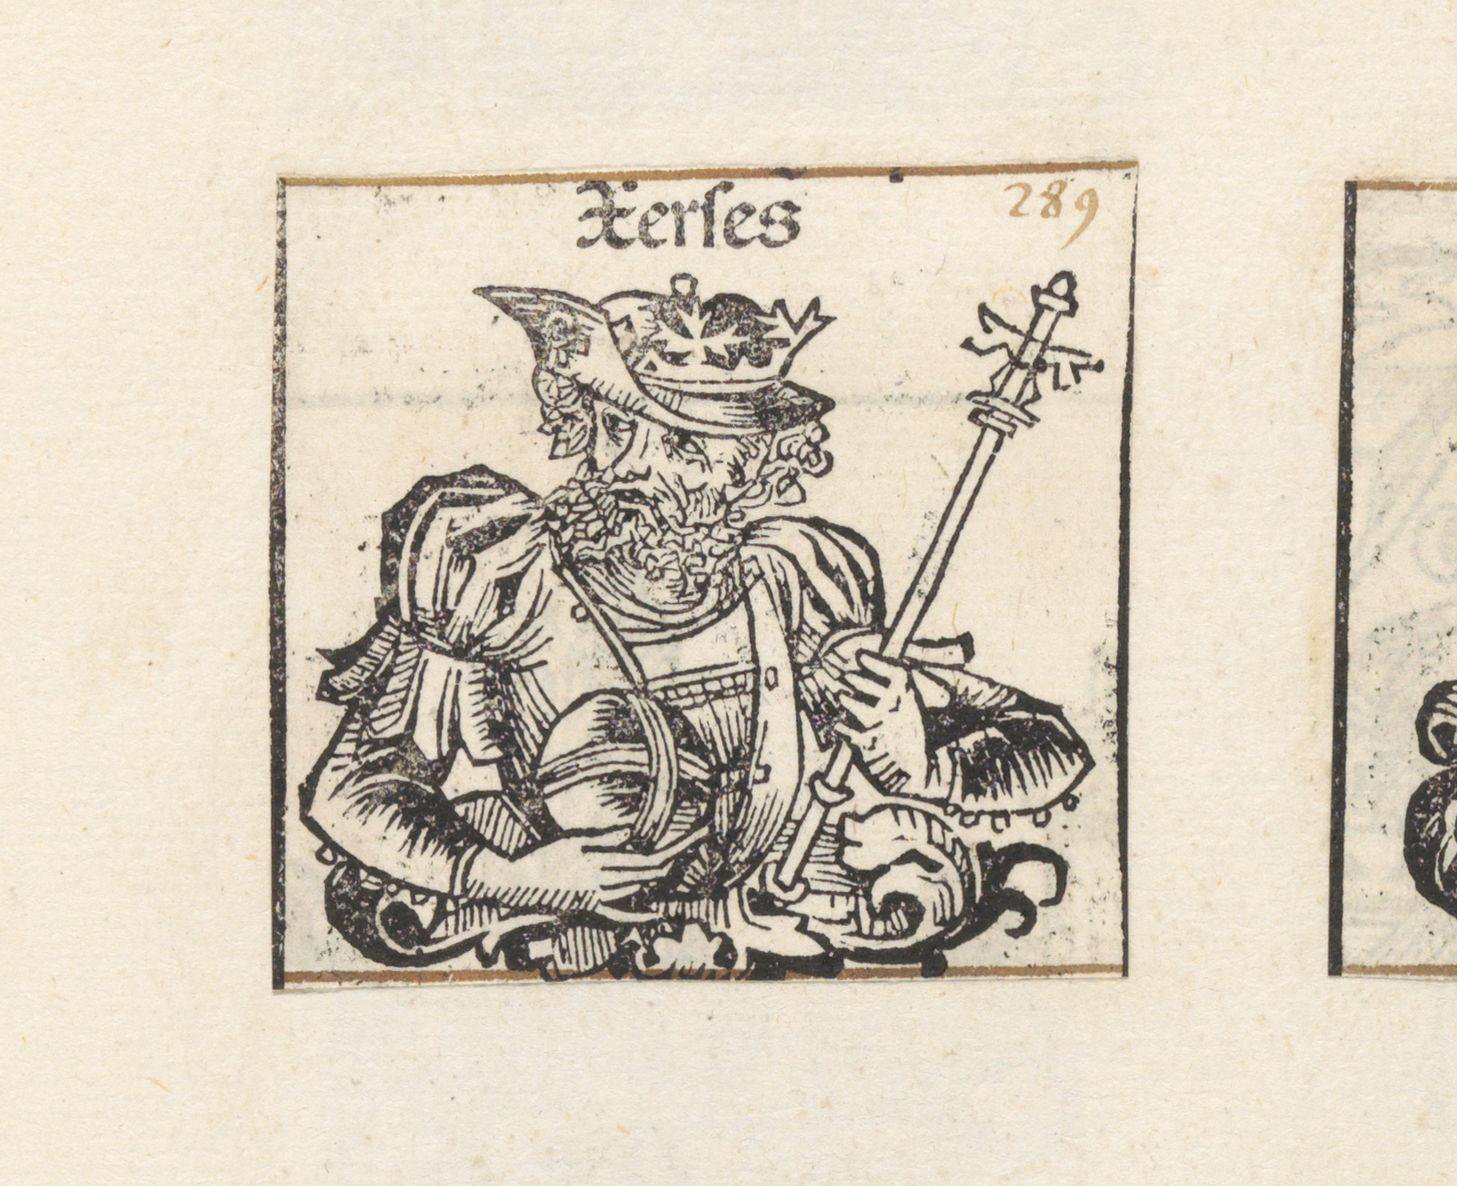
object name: album leaf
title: Xerses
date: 1493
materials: paper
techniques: letterpress printing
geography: nuremberg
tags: king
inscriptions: inscription: ‘289’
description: Een bloemkelk met een koning, naar links omkijkend. In zijn handen heeft hij een scepter en rijksappel. De voorstelling is een onderdeel van de opeenvolging Perzische koningen in de Liber Chronicarum. De tekst identificeert de man als Xerxes II. De prent maakt deel uit van een album.